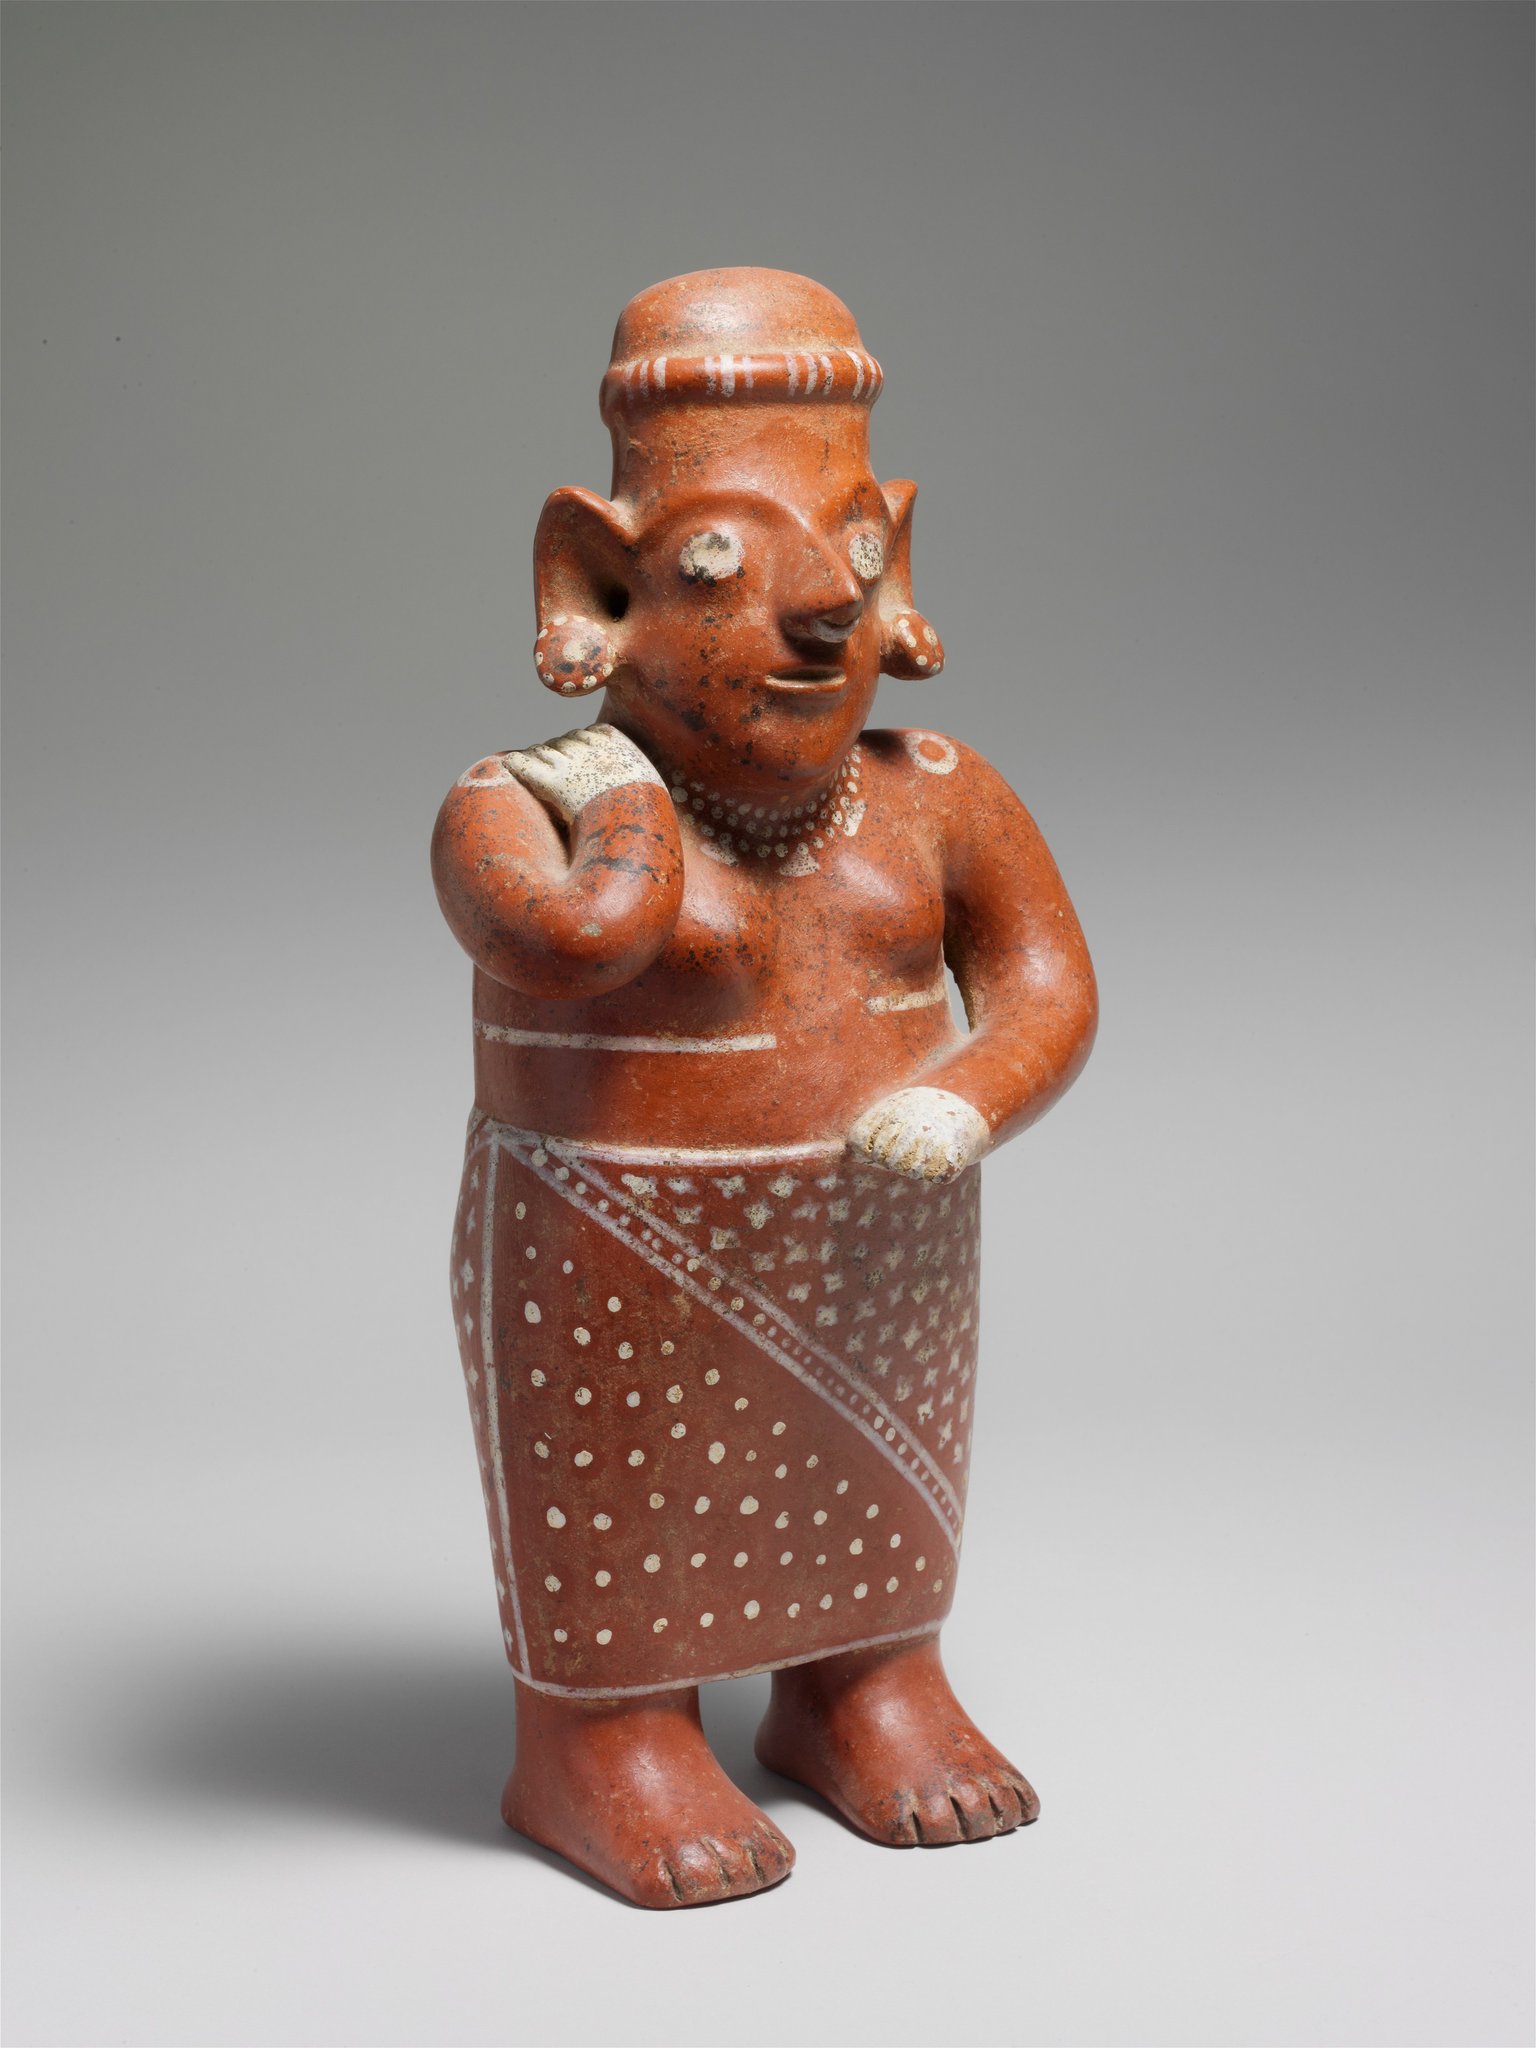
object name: female figure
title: Standing female figure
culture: tala-tonalá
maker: tala-tonalá artist(s)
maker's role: artist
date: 300 BCE-300 CE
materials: ceramic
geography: mexico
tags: women